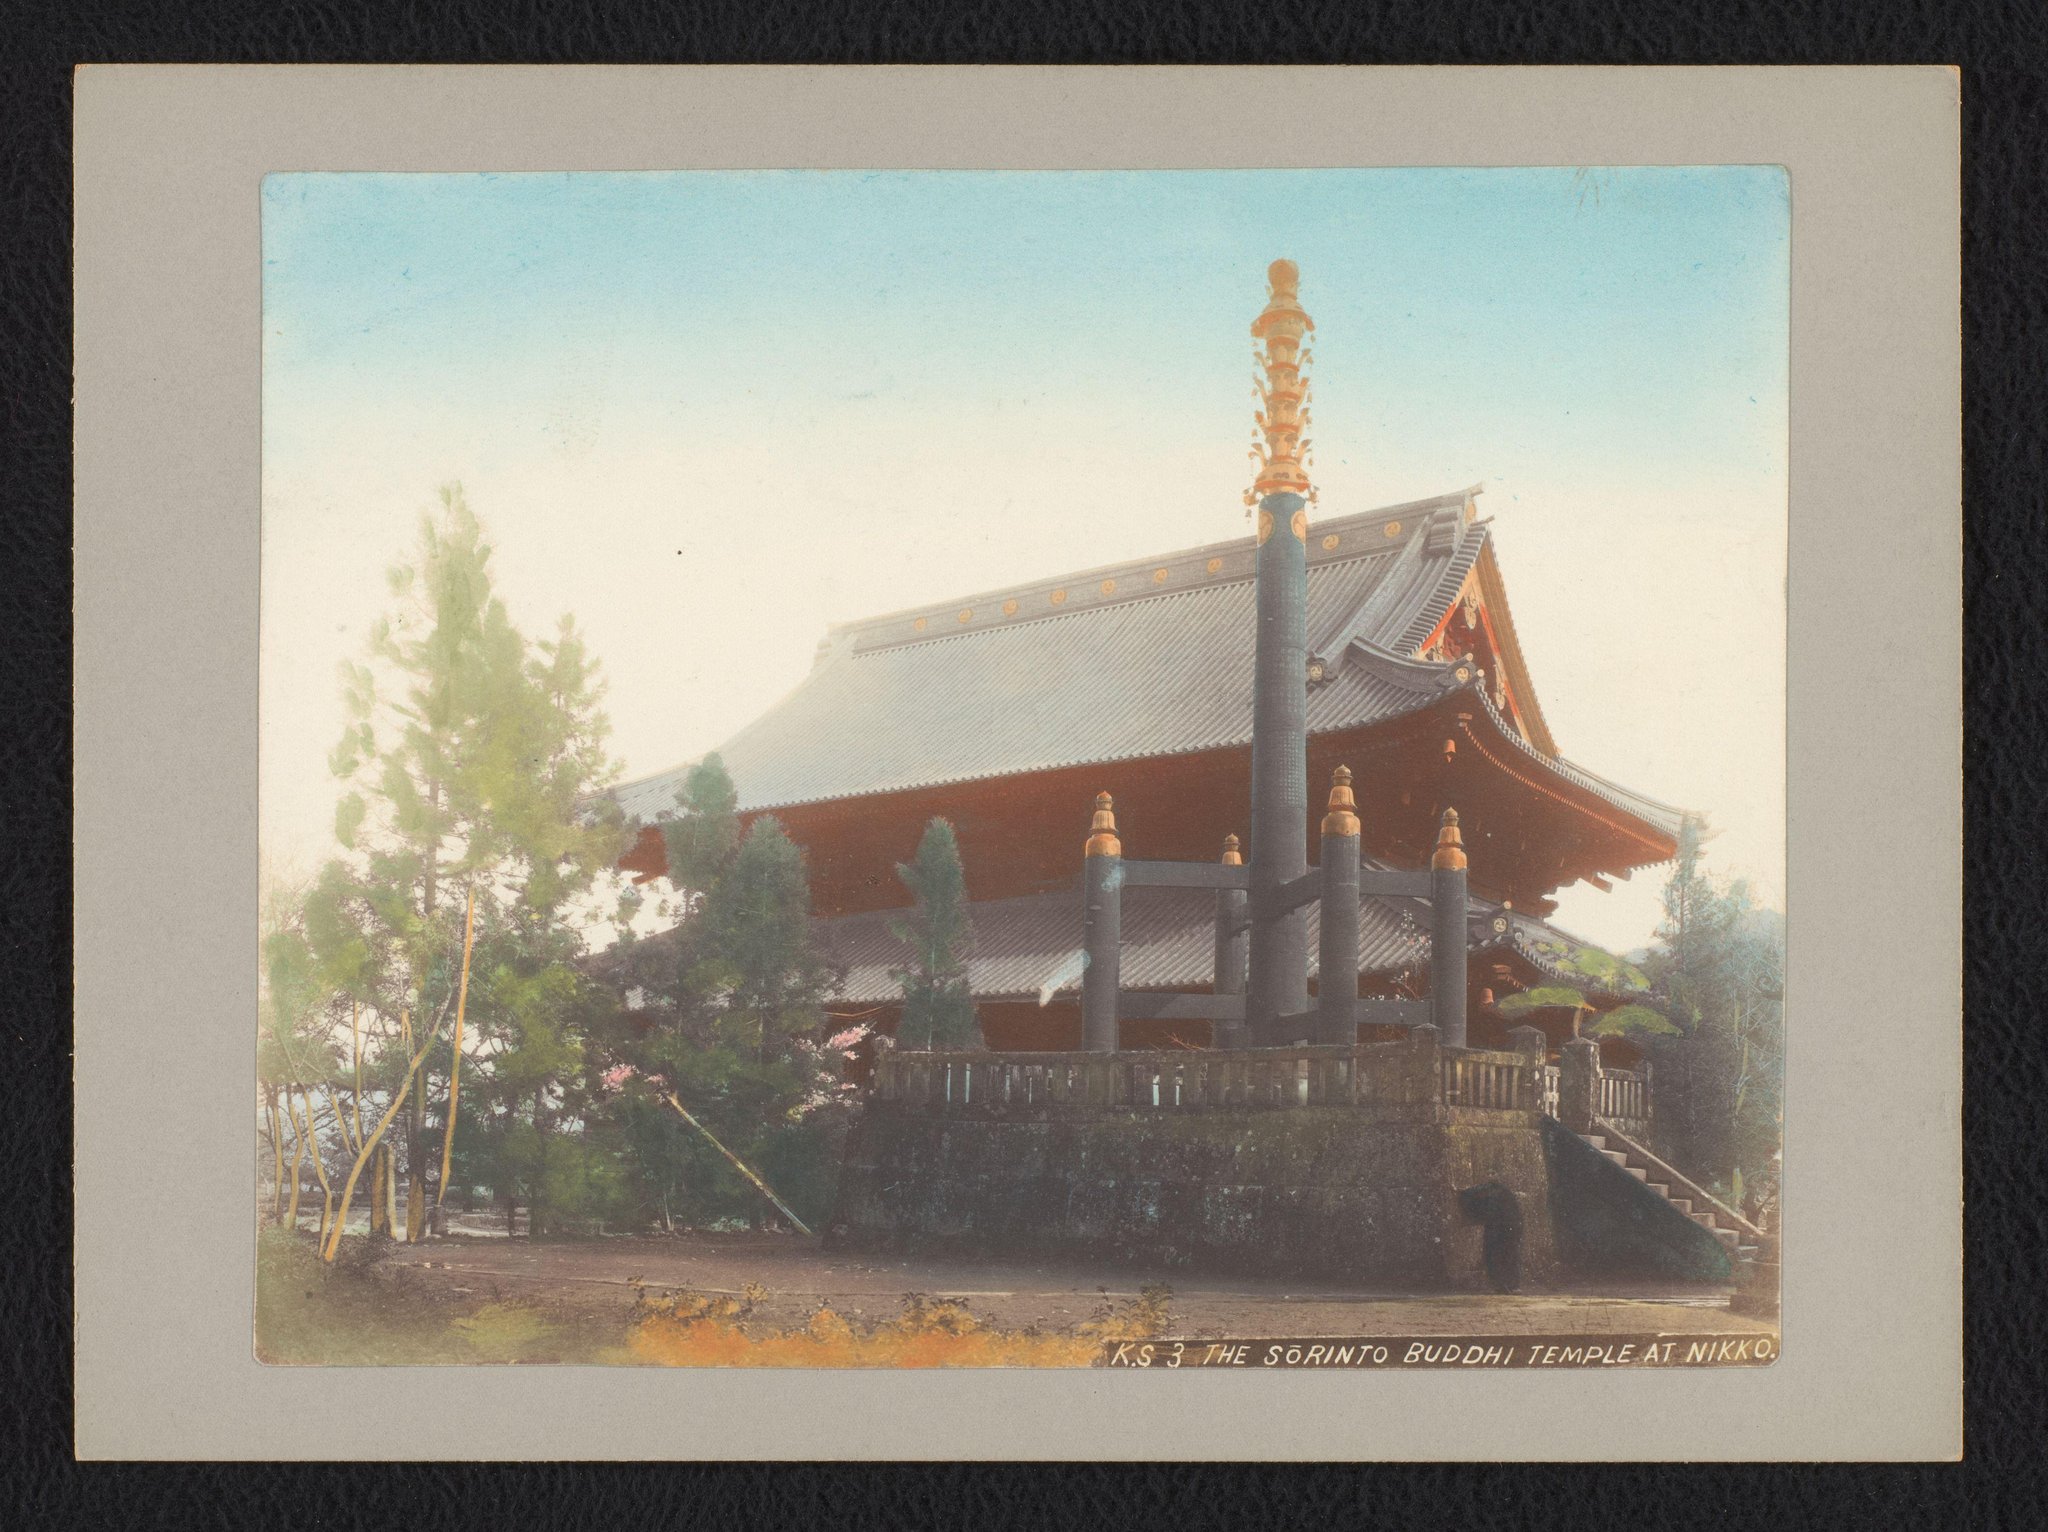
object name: photograph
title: K.S 3 The Sorinto Buddhi Temple at Nikko.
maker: Anonymous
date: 1895-1915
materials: cardboard, photographic support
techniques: salted paper print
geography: nikko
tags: nikko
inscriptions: number: ‘28.’